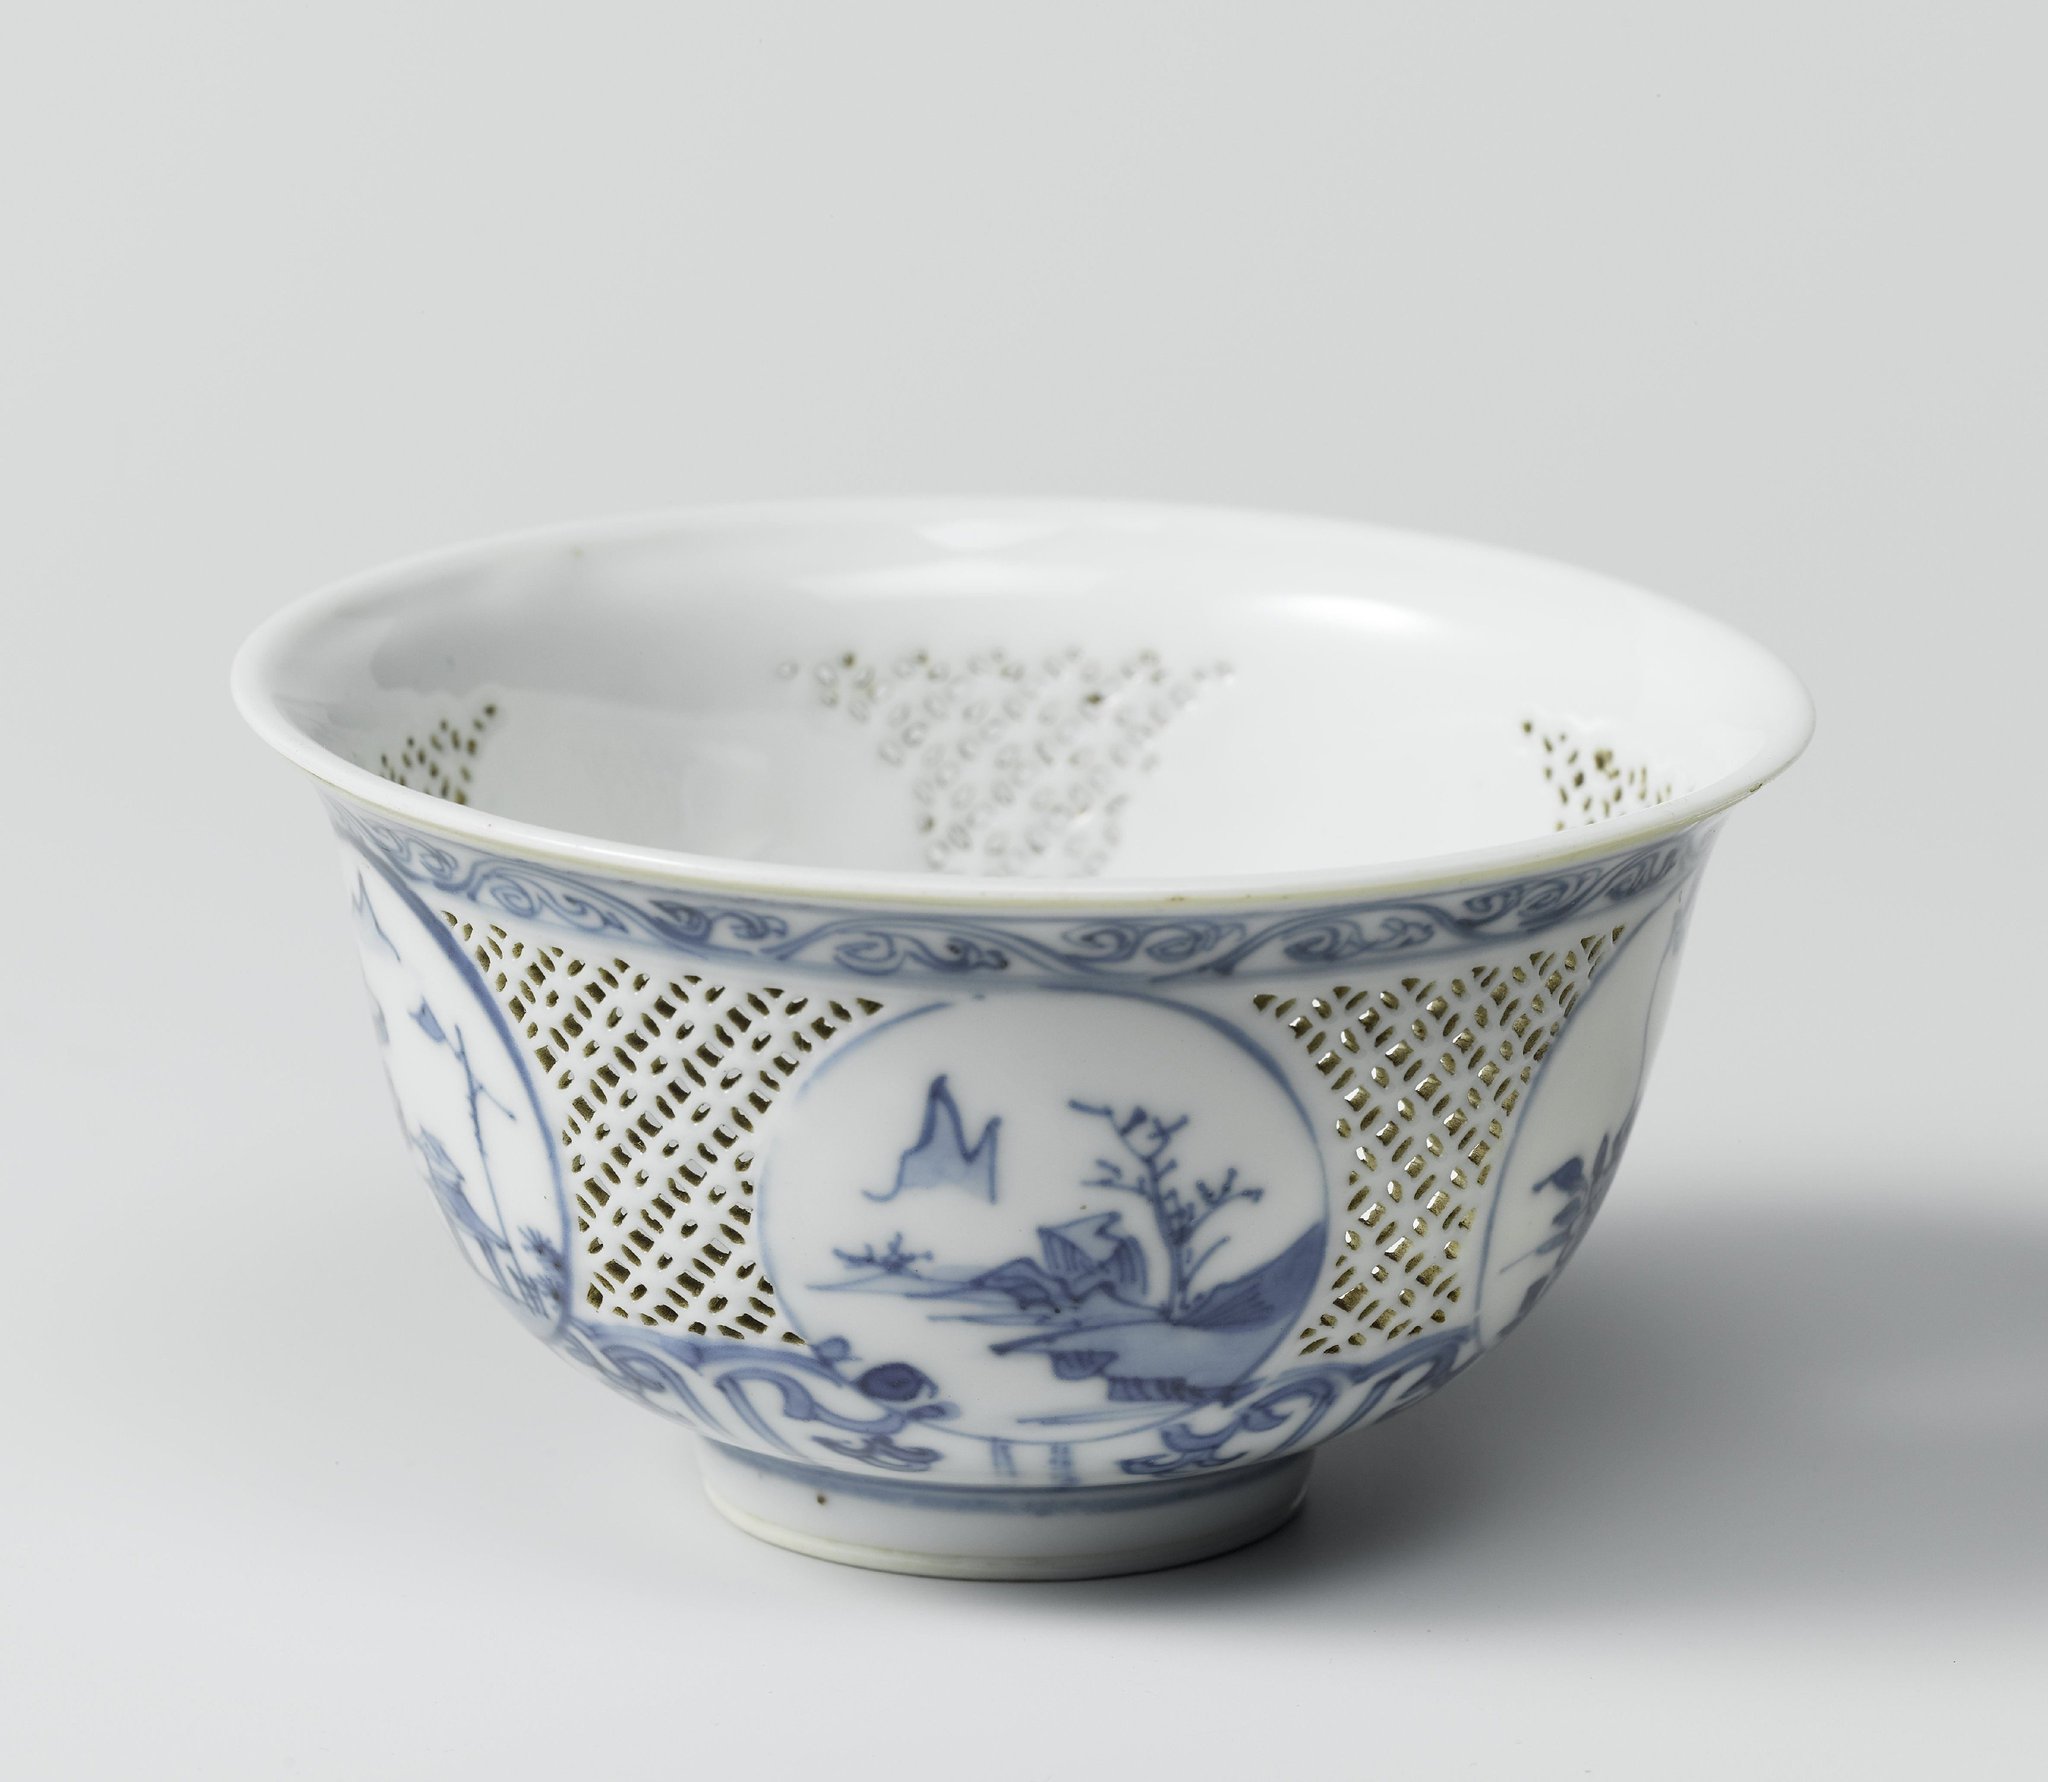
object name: bowl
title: Bell-shaped bowl with pierced sides, landscapes and flowering plants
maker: Anonymous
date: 1625-1649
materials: cobalt, glaze, paint, porcelain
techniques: embroidery, firing, turning, vitrification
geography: china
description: Klokvormige kom van porselein, beschilderd in onderglazuur blauw. De wand is opengewerkt (ajourwerk in een muntmotief) met hierin vijf medaillons uitgespaard. In de medaillons bloeiende planten of een rivierlandschap. Op de rand een band met ranken; boven de voet een band met bloembladvormige vakken met ranken. Overgangsporselein in blauw-wit.